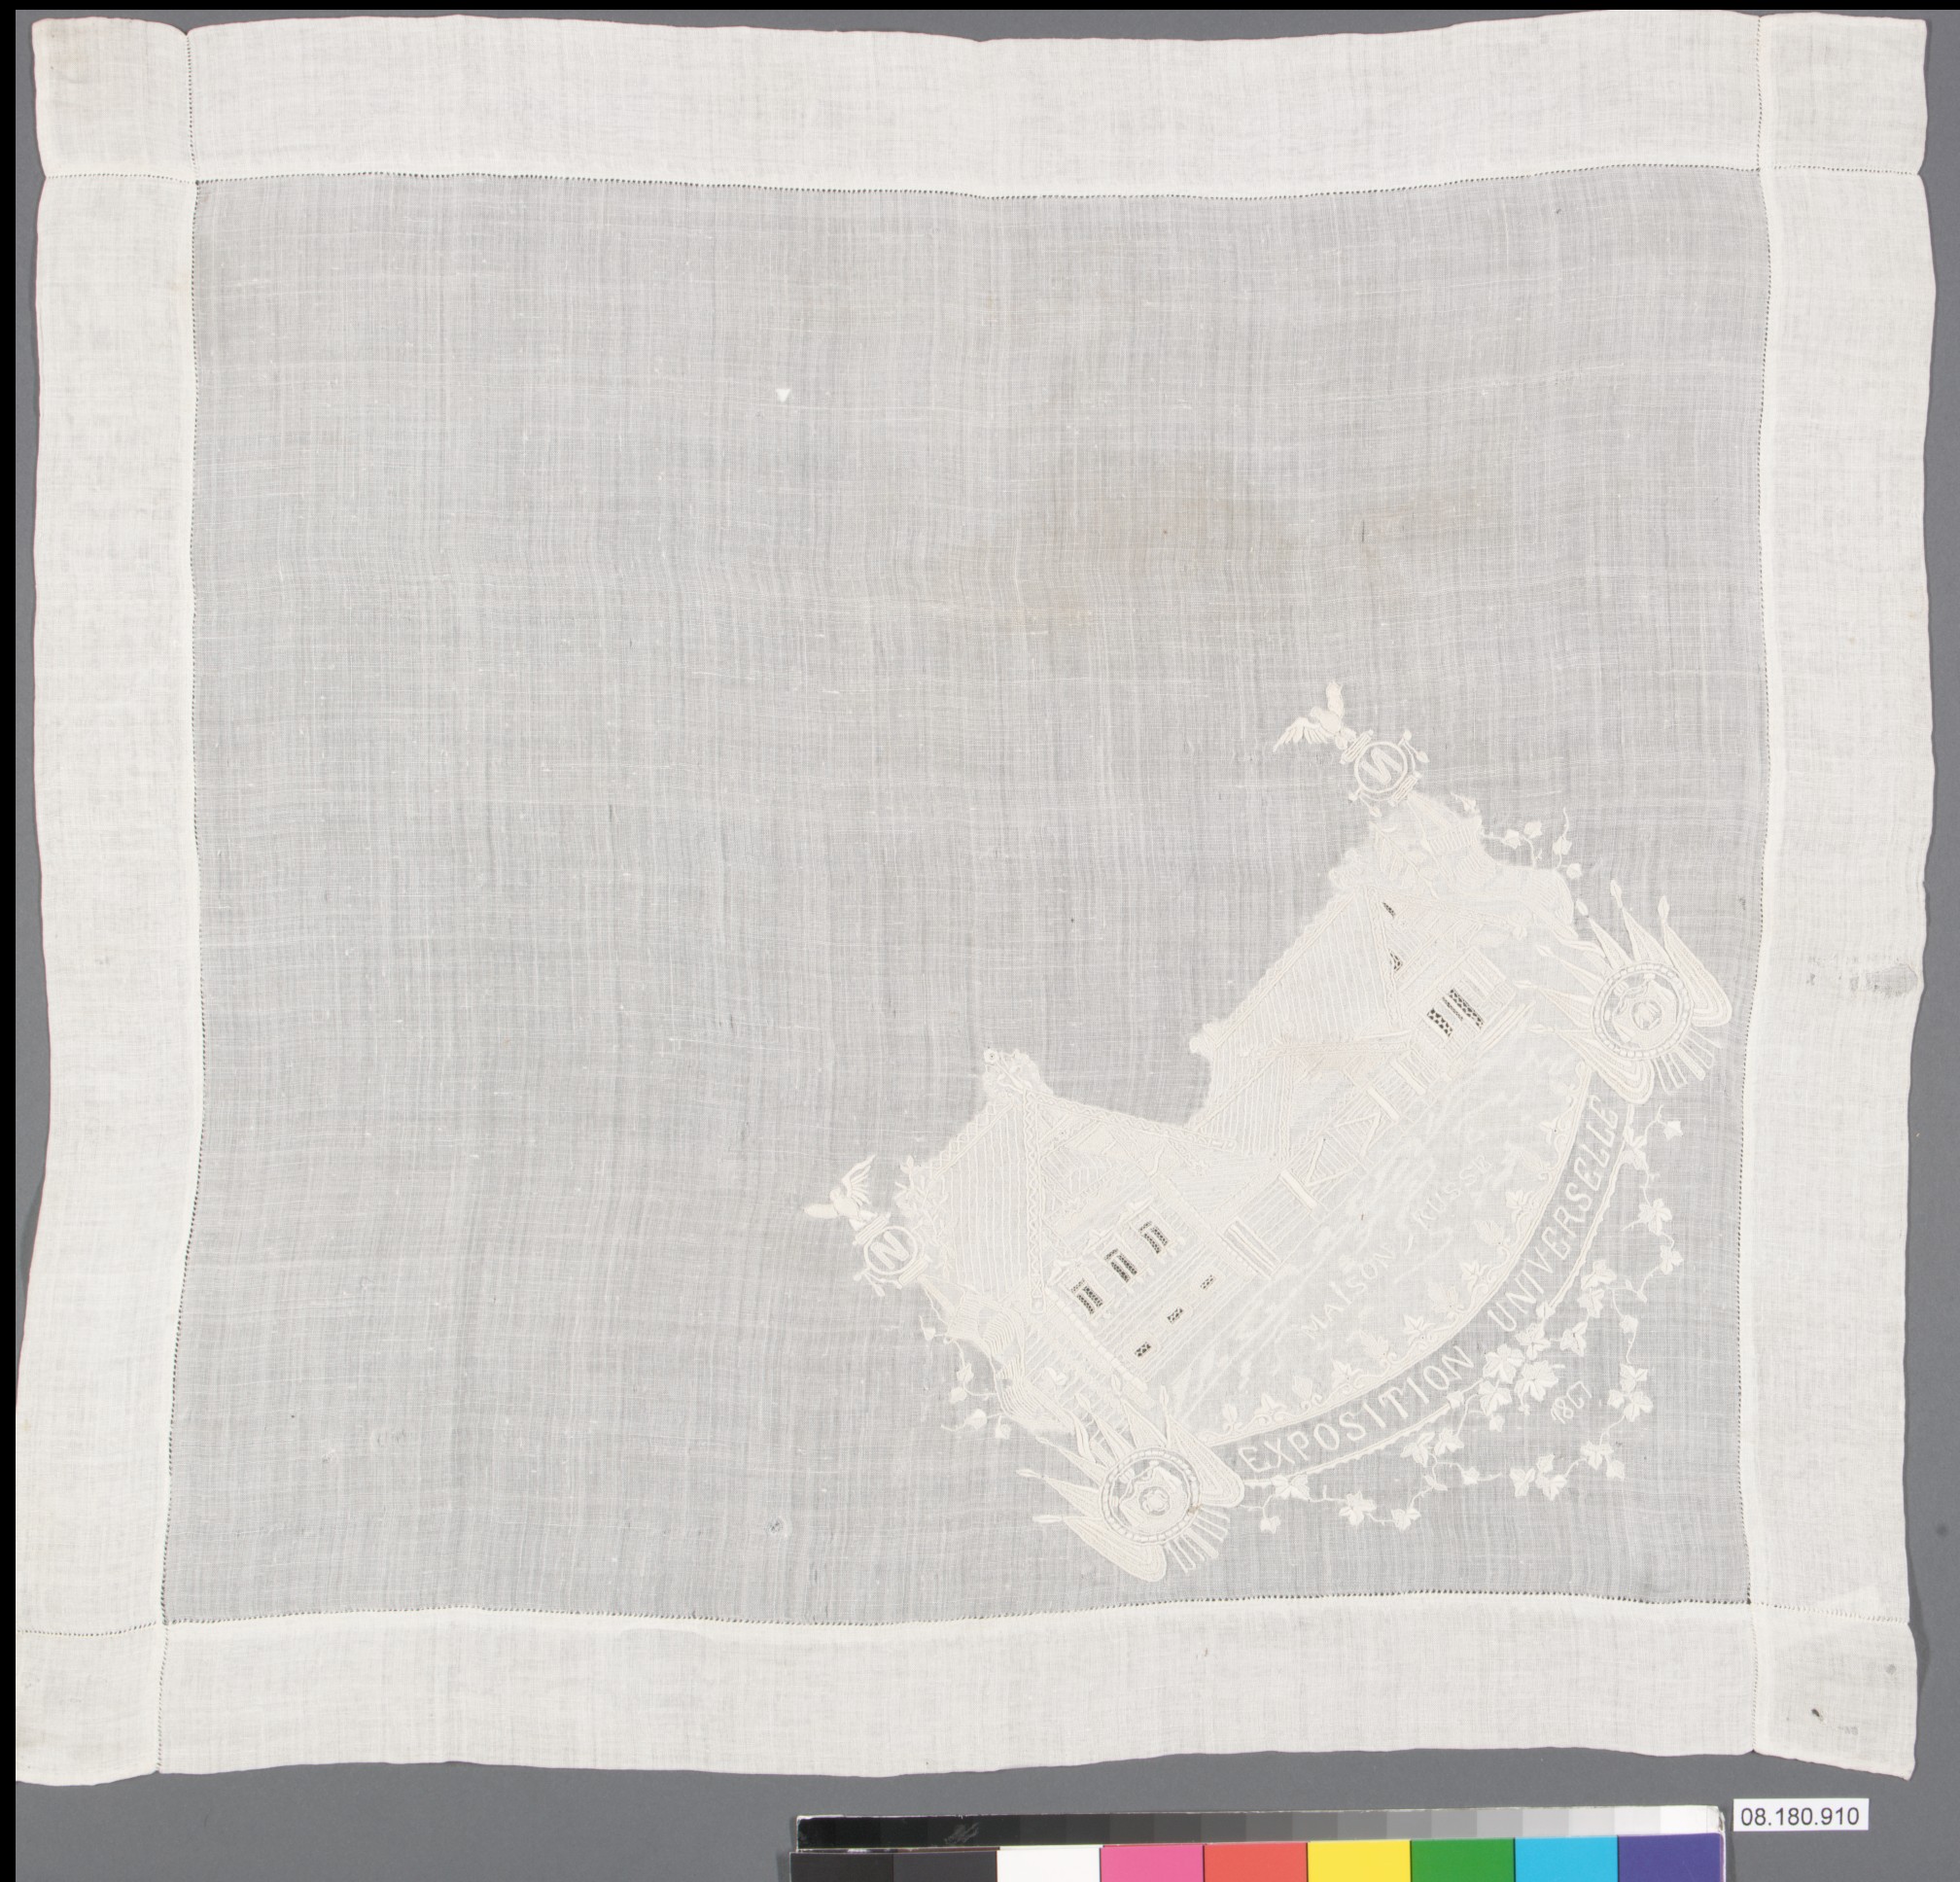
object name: handkerchief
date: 1801-1900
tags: houses